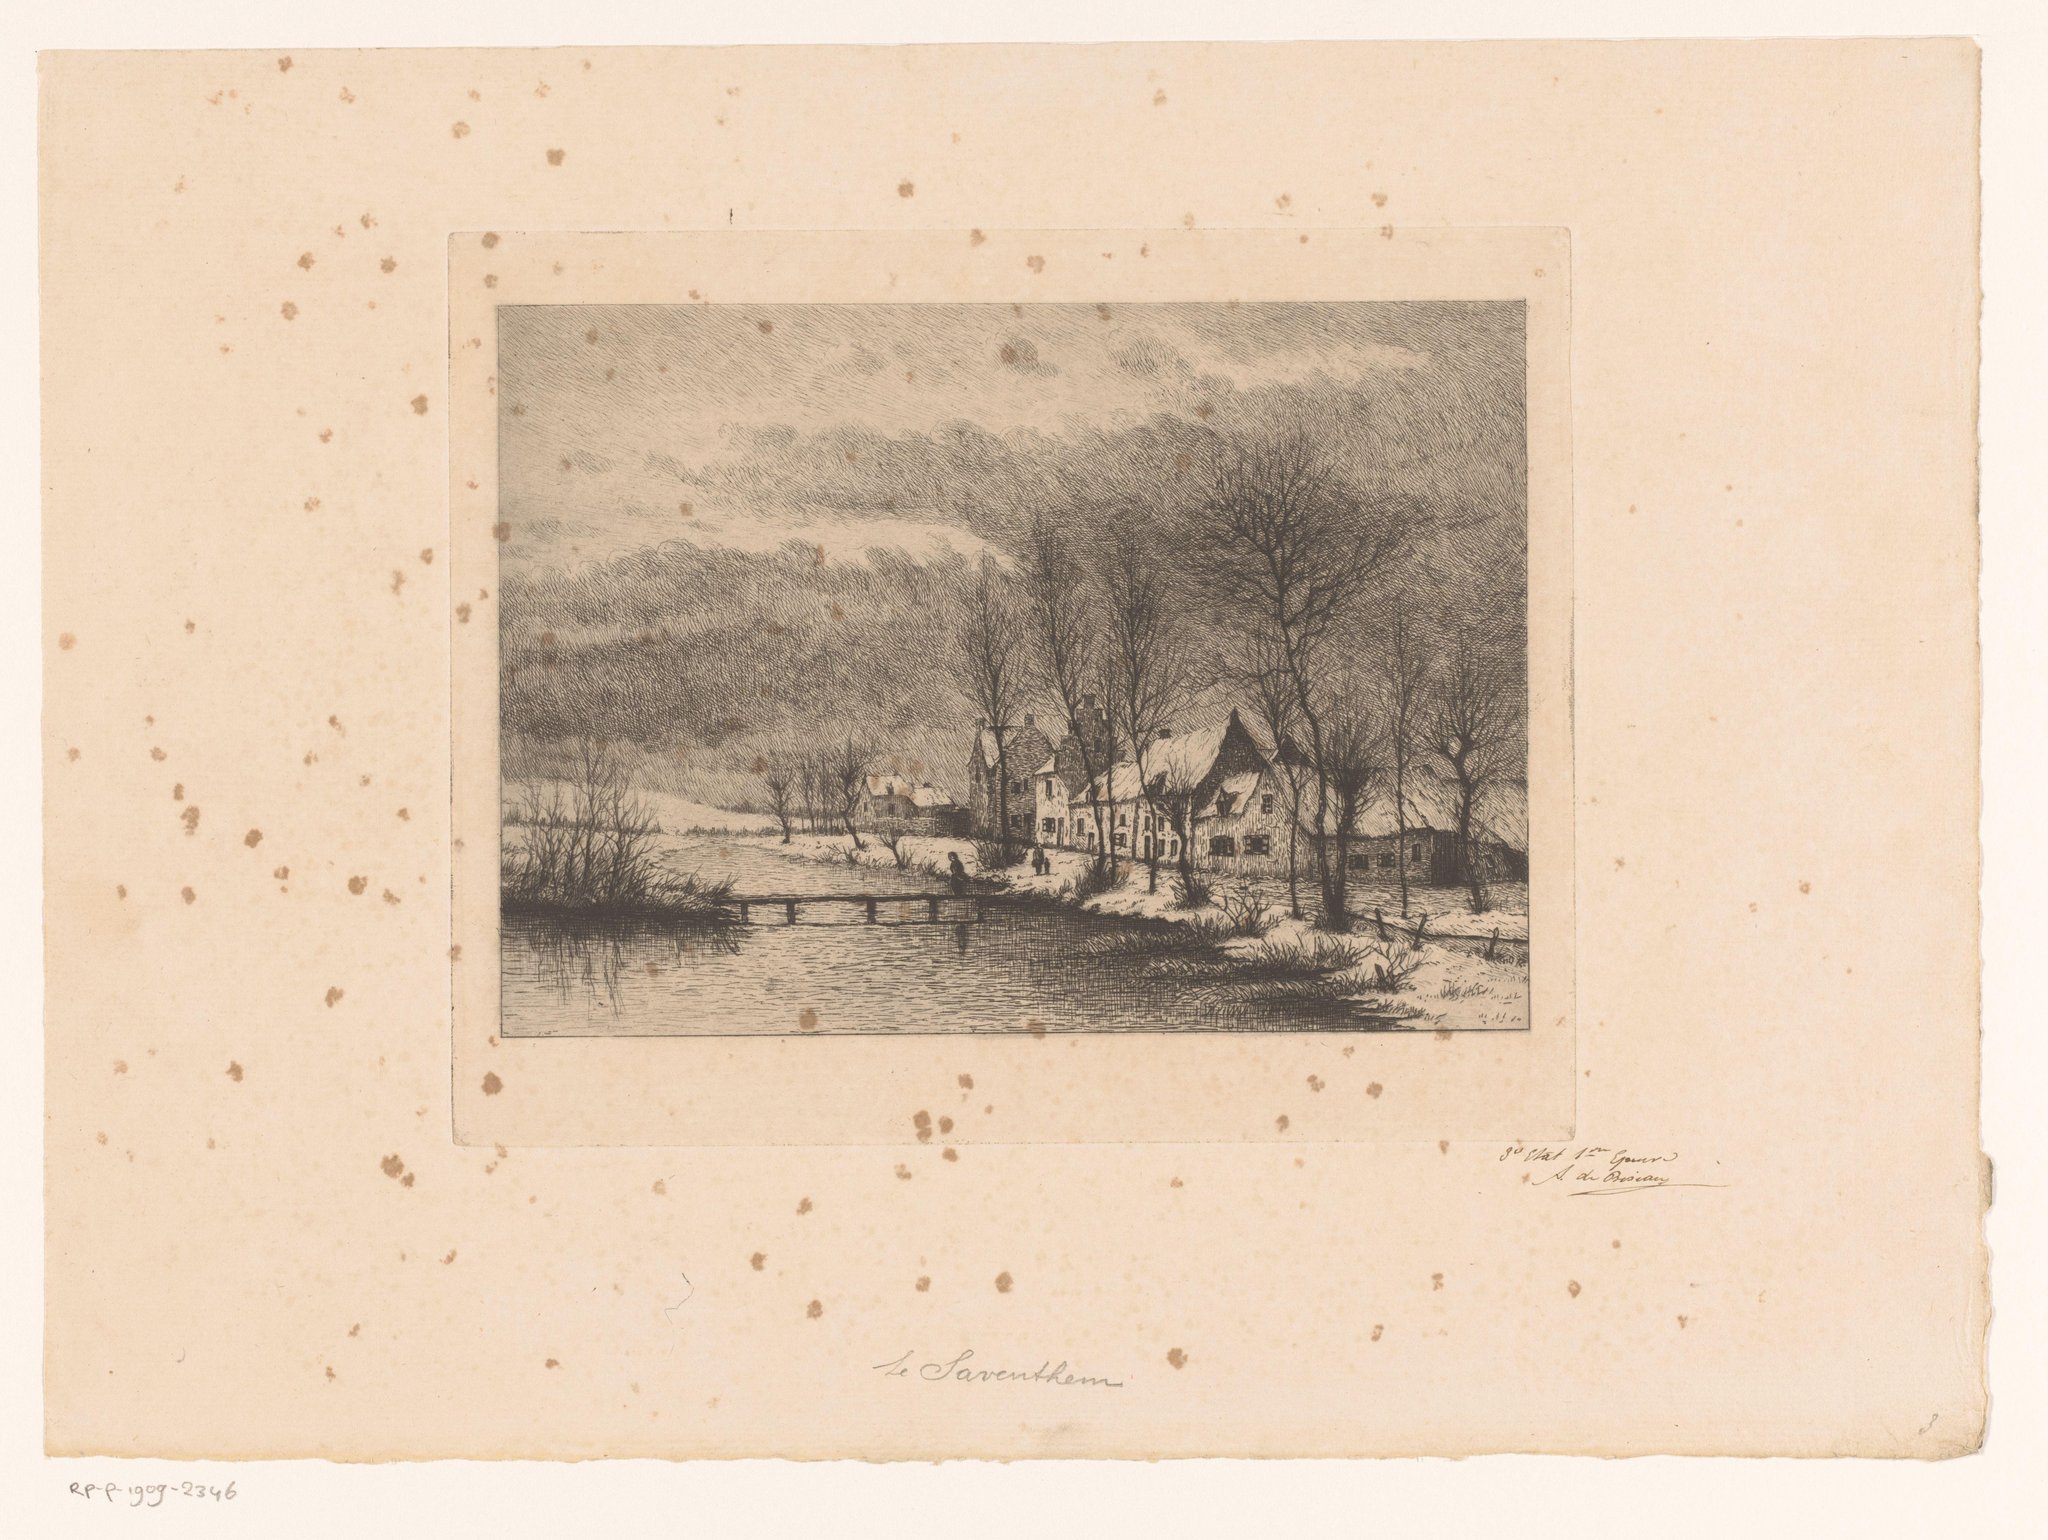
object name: print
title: Sneeuwgezicht met dorpshuizen aan een plas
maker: aristide de biseau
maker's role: print maker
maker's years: 1844-1883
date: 1854-1883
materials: paper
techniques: etching, intaglio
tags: landscapes, village, lake, winter landscape; landscape symbolizing winter (the four seasons of the year)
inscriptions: inscription: ‘3e Etat 1e Epreuve’, collector's mark: Lugt 2228